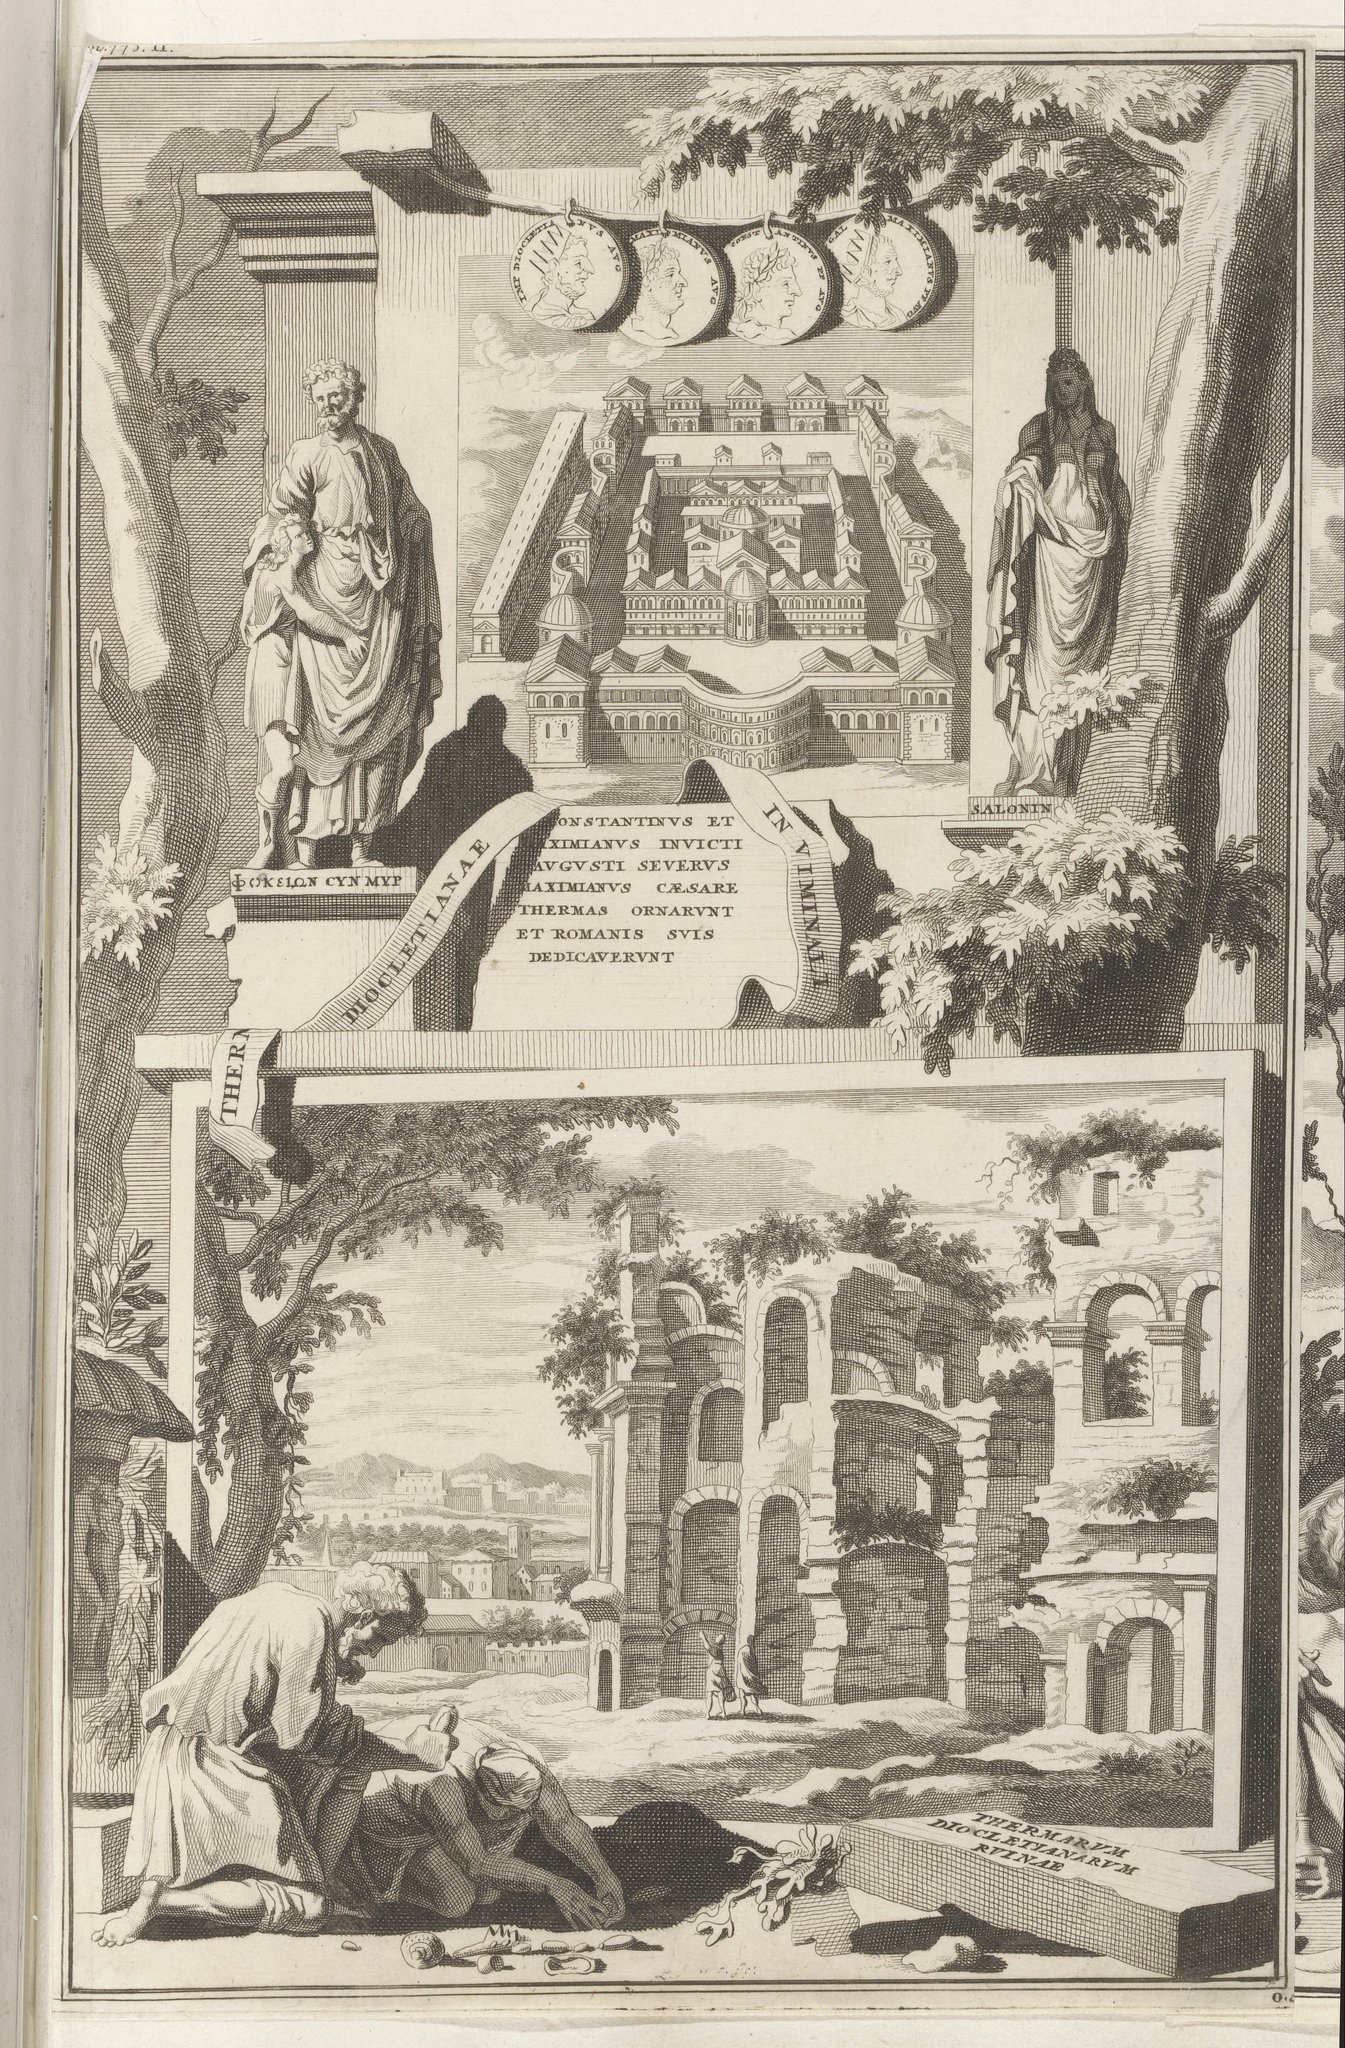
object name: album leaf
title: Magesyn der Italiaense gebouwen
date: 1704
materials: paper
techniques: etching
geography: netherlands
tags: treasure hunting, goldrush, landscape with ruins, public baths, piece of sculpture, reproduction of a piece of sculpture, representation of real building (either existing or having existed)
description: Boven een reconstructie van de Thermen van Diocletianus, geflankeerd door beelden en bomen. Onder een voorstelling van de ruïnes van de thermen met op de voorgrond twee schatzoekers. Bijschriften op stenen blokken bij beide voorstellingen. De prent maakt deel uit van een album.